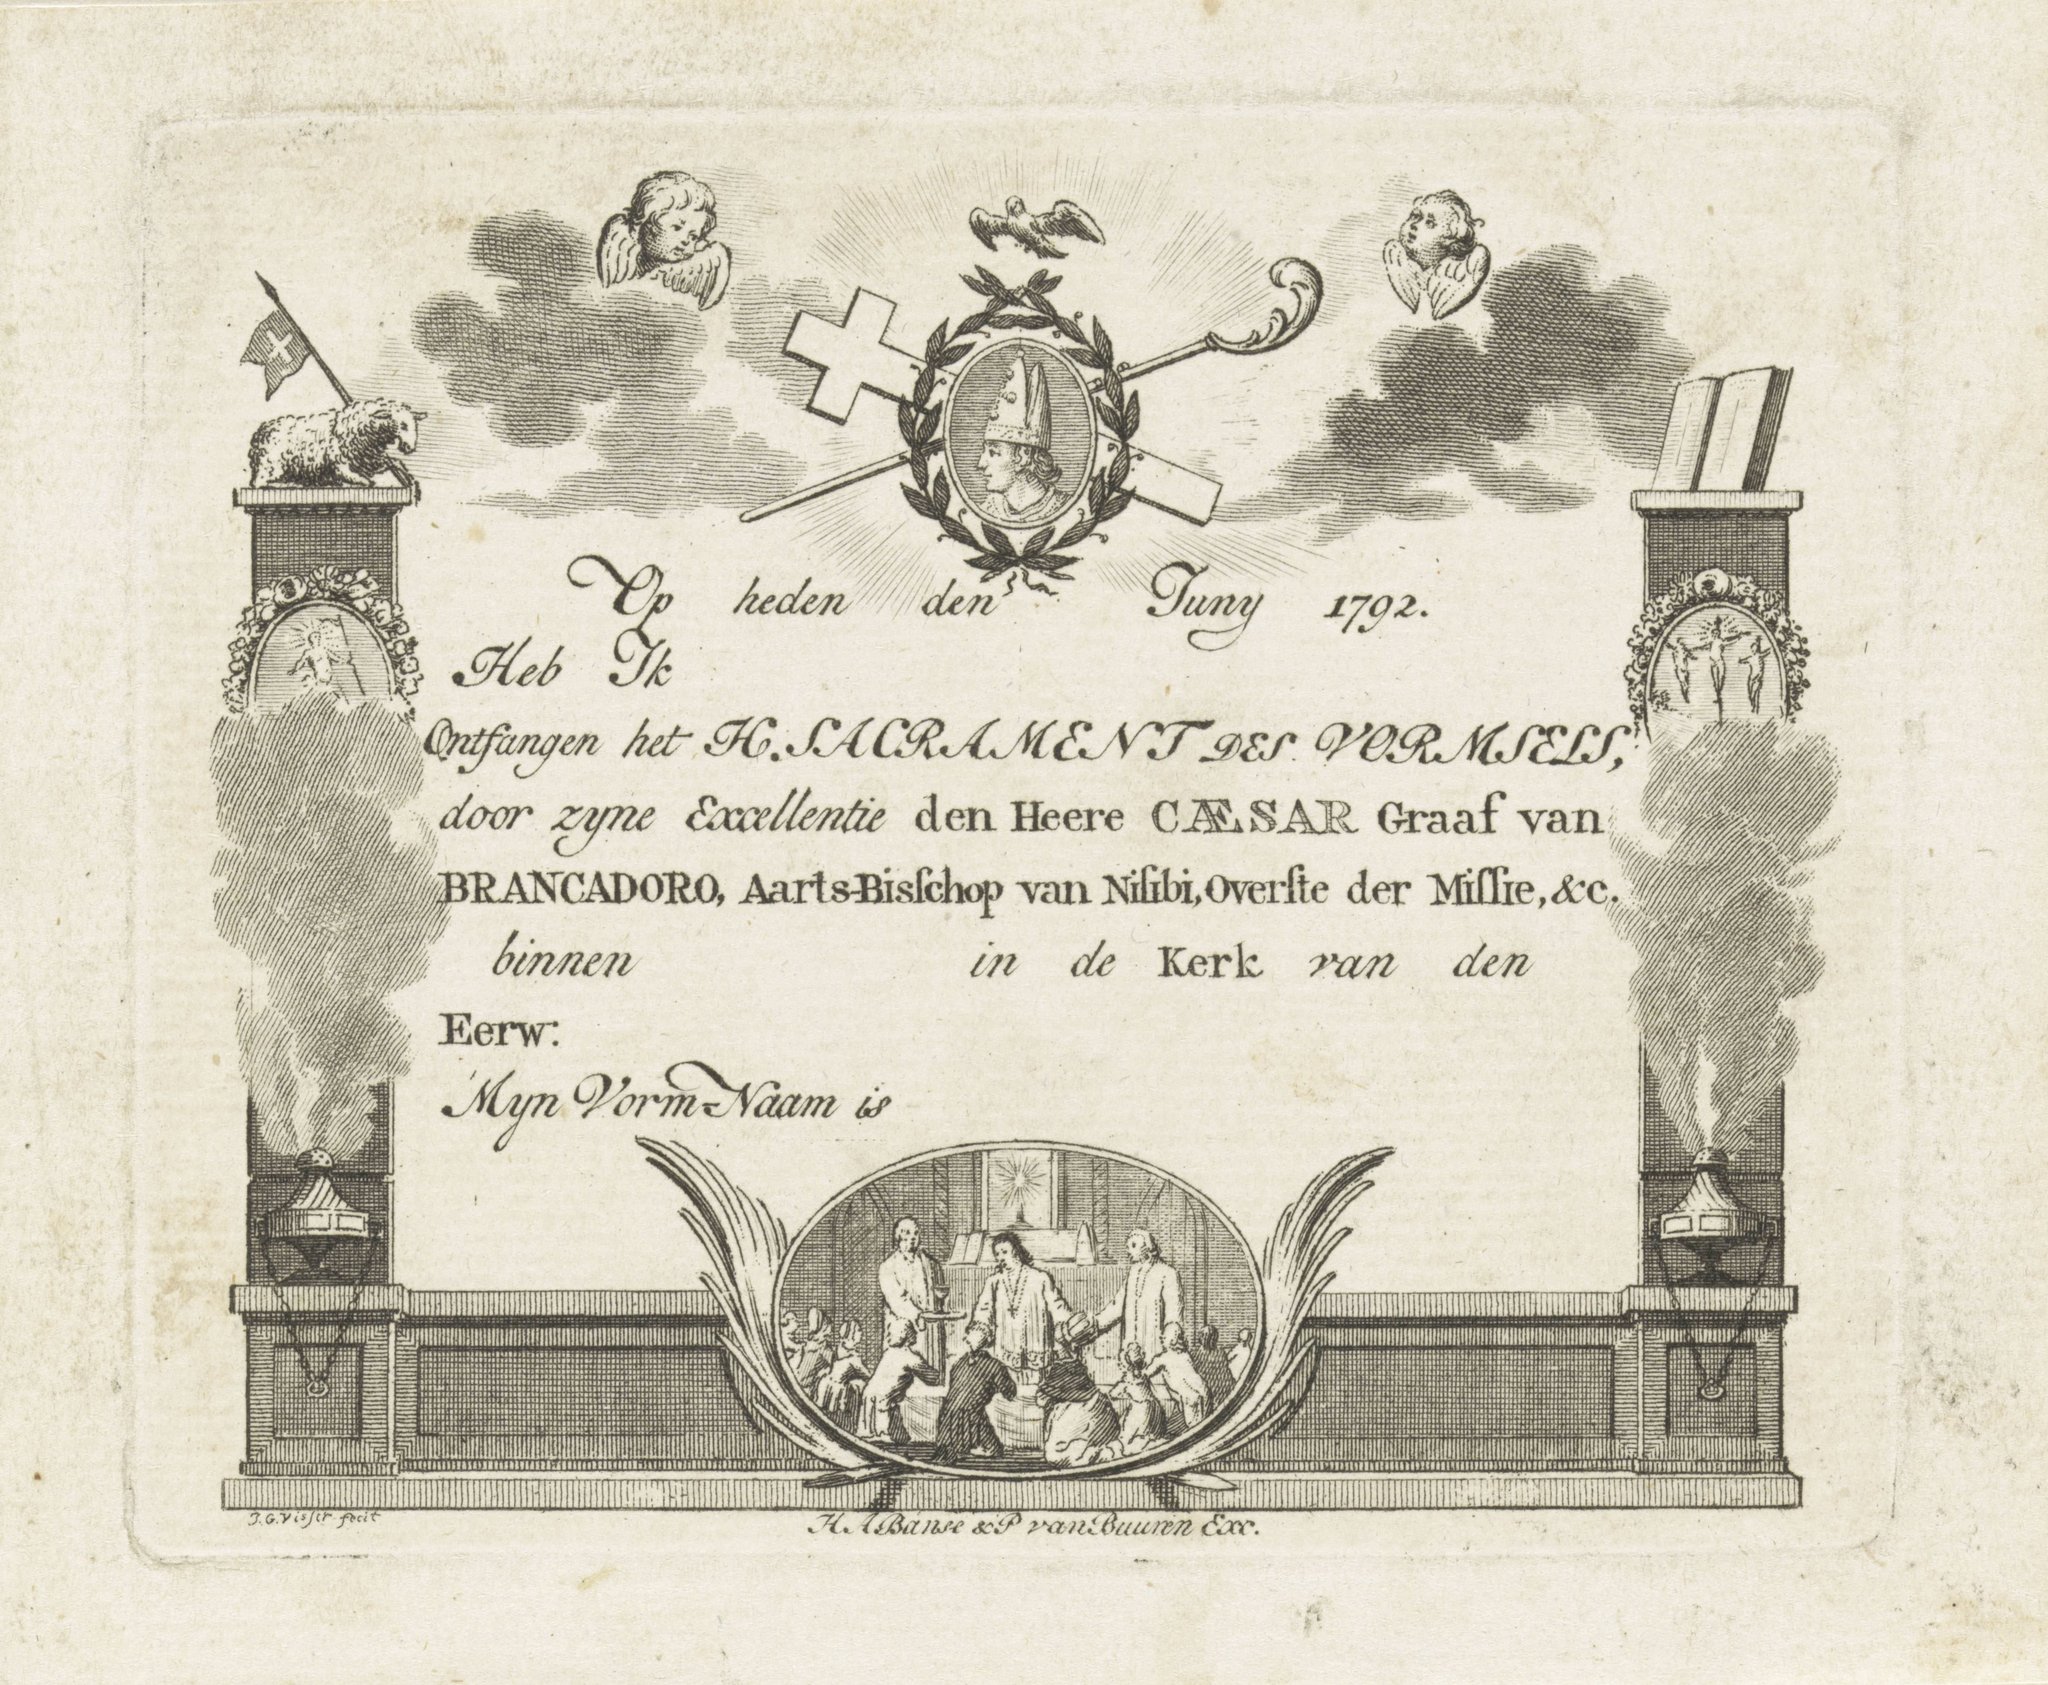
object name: ontvangstbewijs, kwitantie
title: Bewijs van ontvangst van het vormsel van Cesare Brancadoro, aartsbisschop van Nisibi, 1792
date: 1792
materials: paper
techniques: engraving, etching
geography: amsterdam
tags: rome, confirmation ~ the second of the seven sacraments, amsterdam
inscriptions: collector's mark: Lugt 2228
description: Bewijs van het ontvangen van het vormsel van Cesare Brancadoro, aartsbisschop van Nisibi, in Amsterdam in juni 1792. De exacte datum, de naam van de ontvanger en van de kerk zijn niet ingevuld.